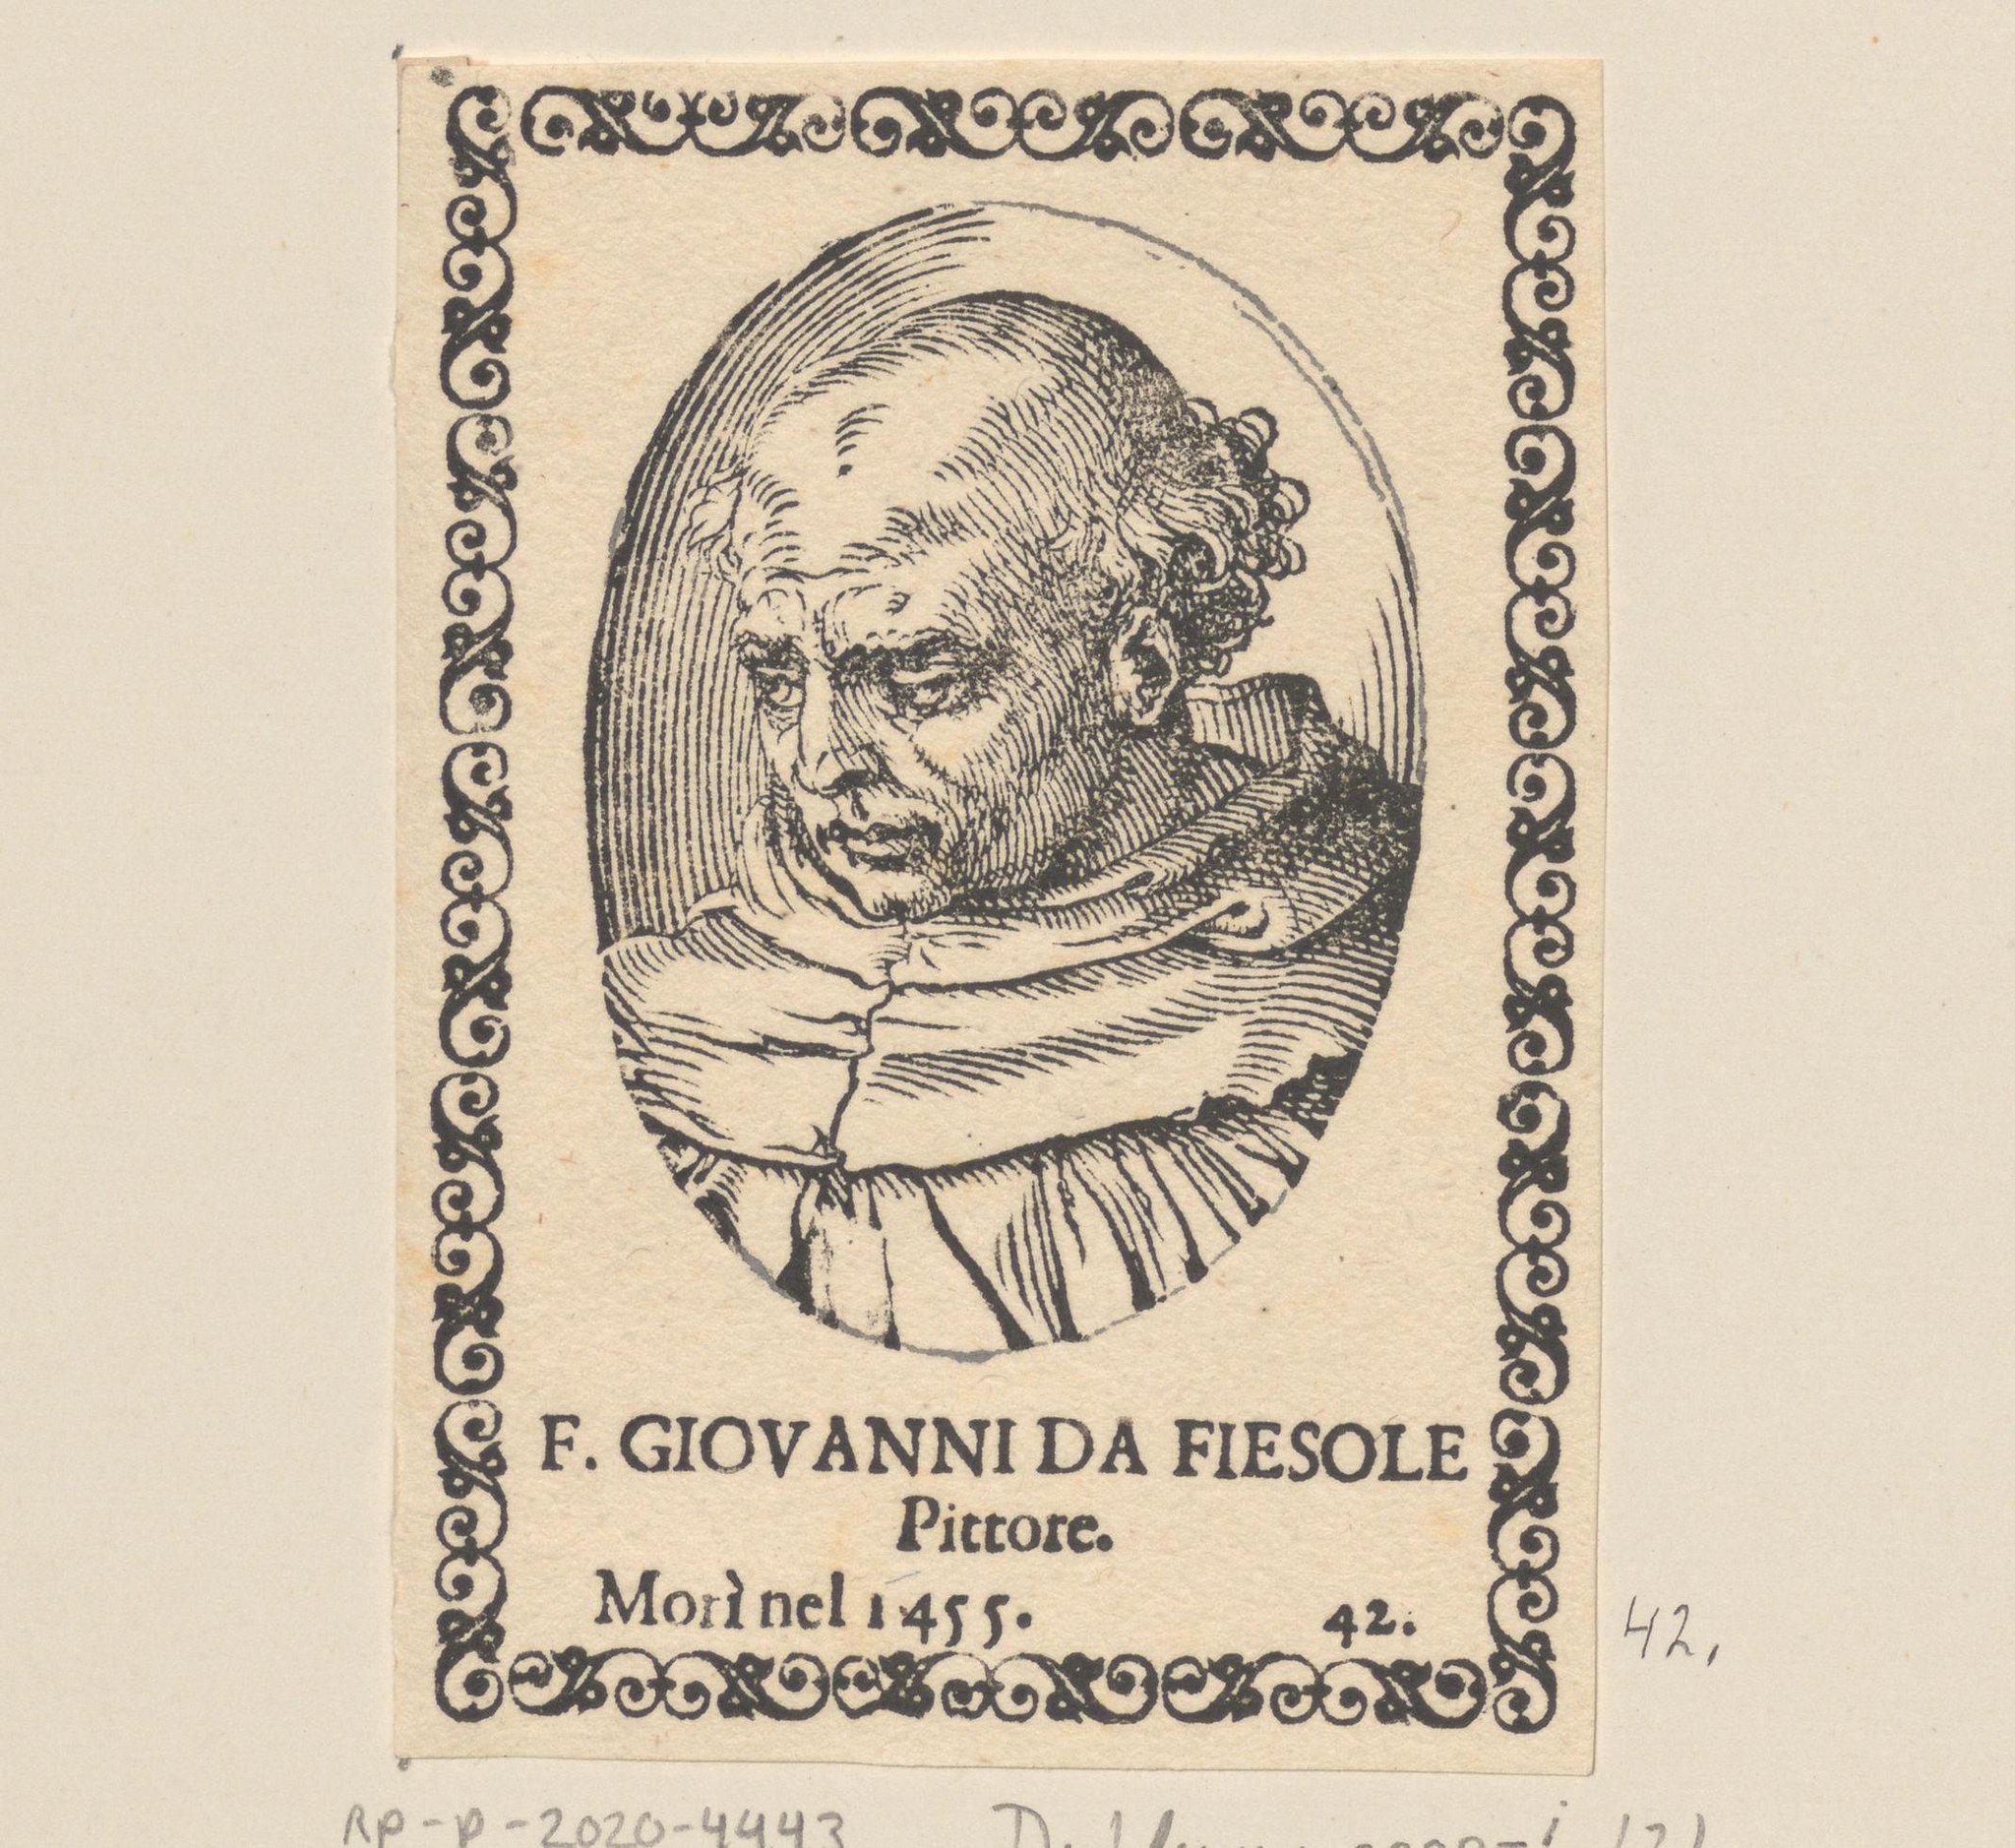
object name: print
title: F. Giovanni da Fiesole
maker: cristoforo coriolano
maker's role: print maker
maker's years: 1540-1610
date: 1568-1650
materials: paper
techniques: letterpress printing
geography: italy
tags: rome, painter, fra angelico, historical persons, monk(s), friar(s), portrait, self-portrait of painter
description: Prent komt uit een editie van Vasari's 'Vite'. Prent met andere omlijsting is gebruikt in edities uit 1568 en 1647.